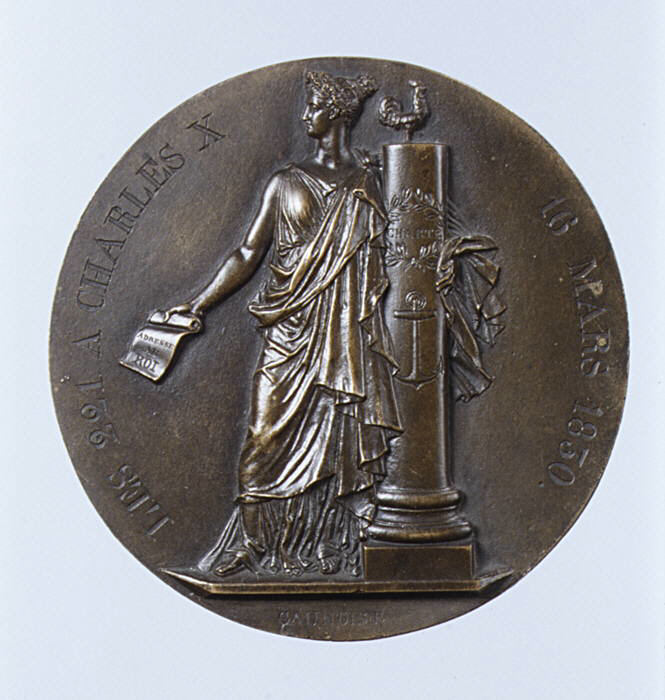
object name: medallion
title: Commemorating the Vote of March 16, 1830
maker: françois augustin caunois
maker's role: maker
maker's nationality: french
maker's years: 1787-1859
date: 1830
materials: bronze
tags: women,roosters